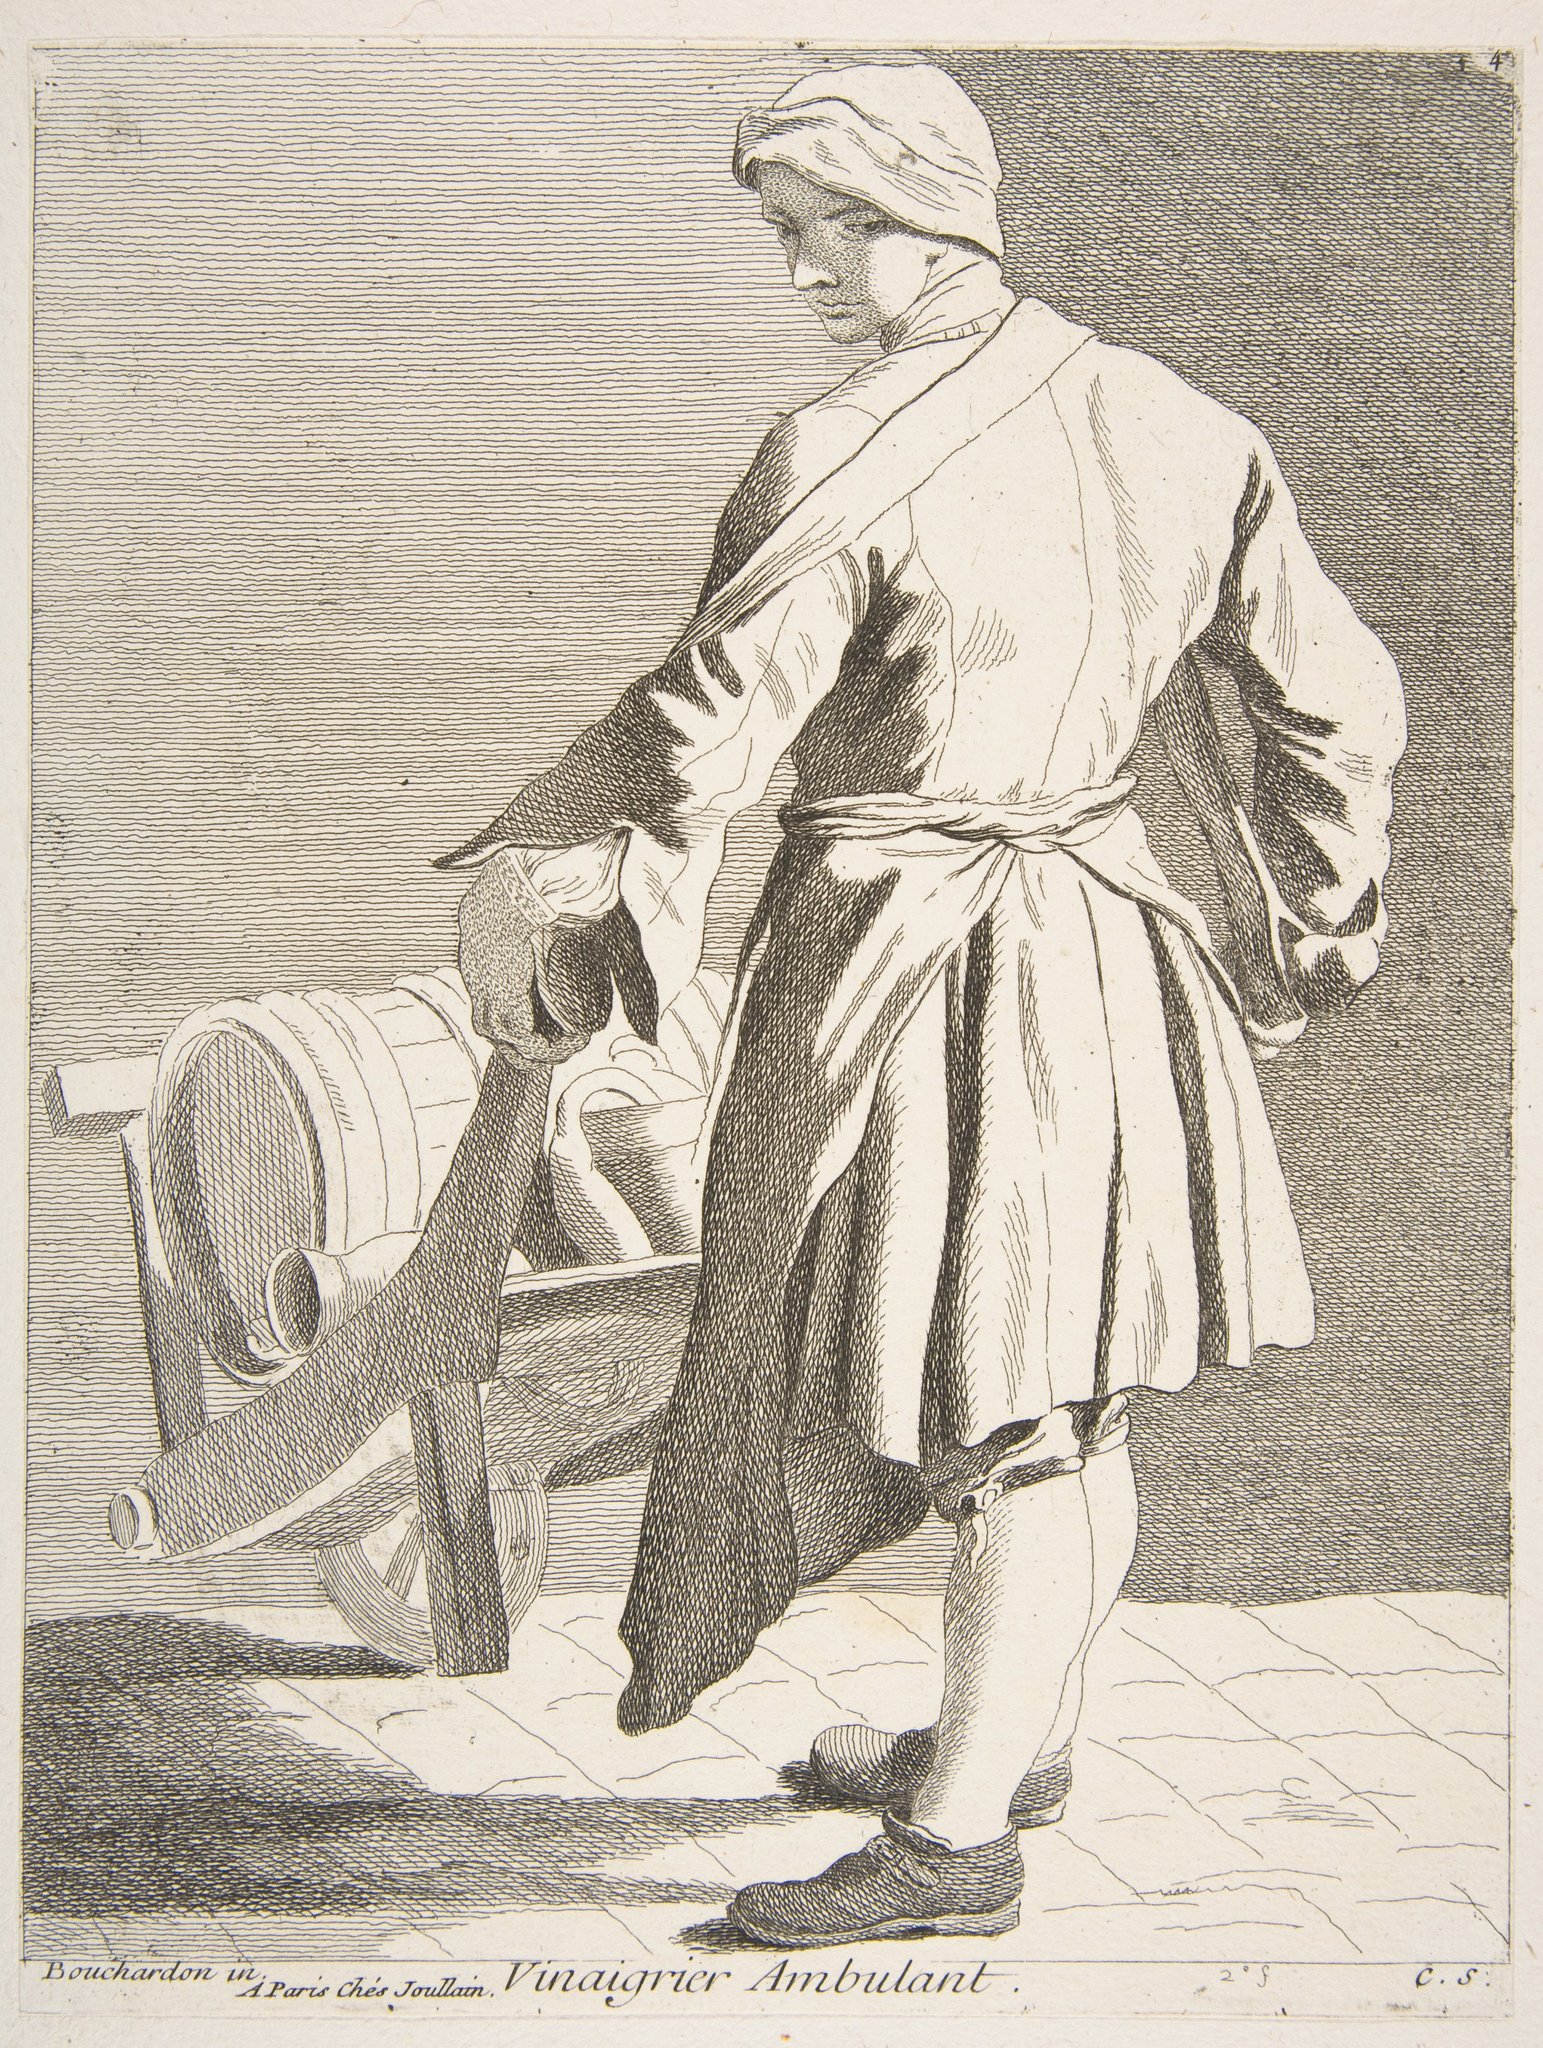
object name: print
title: Wandering Vinegar Seller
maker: anne claude philippe de tubières, comte de caylus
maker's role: artist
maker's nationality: french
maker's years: 1692-1765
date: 1738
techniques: engraving, etching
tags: men,barrels